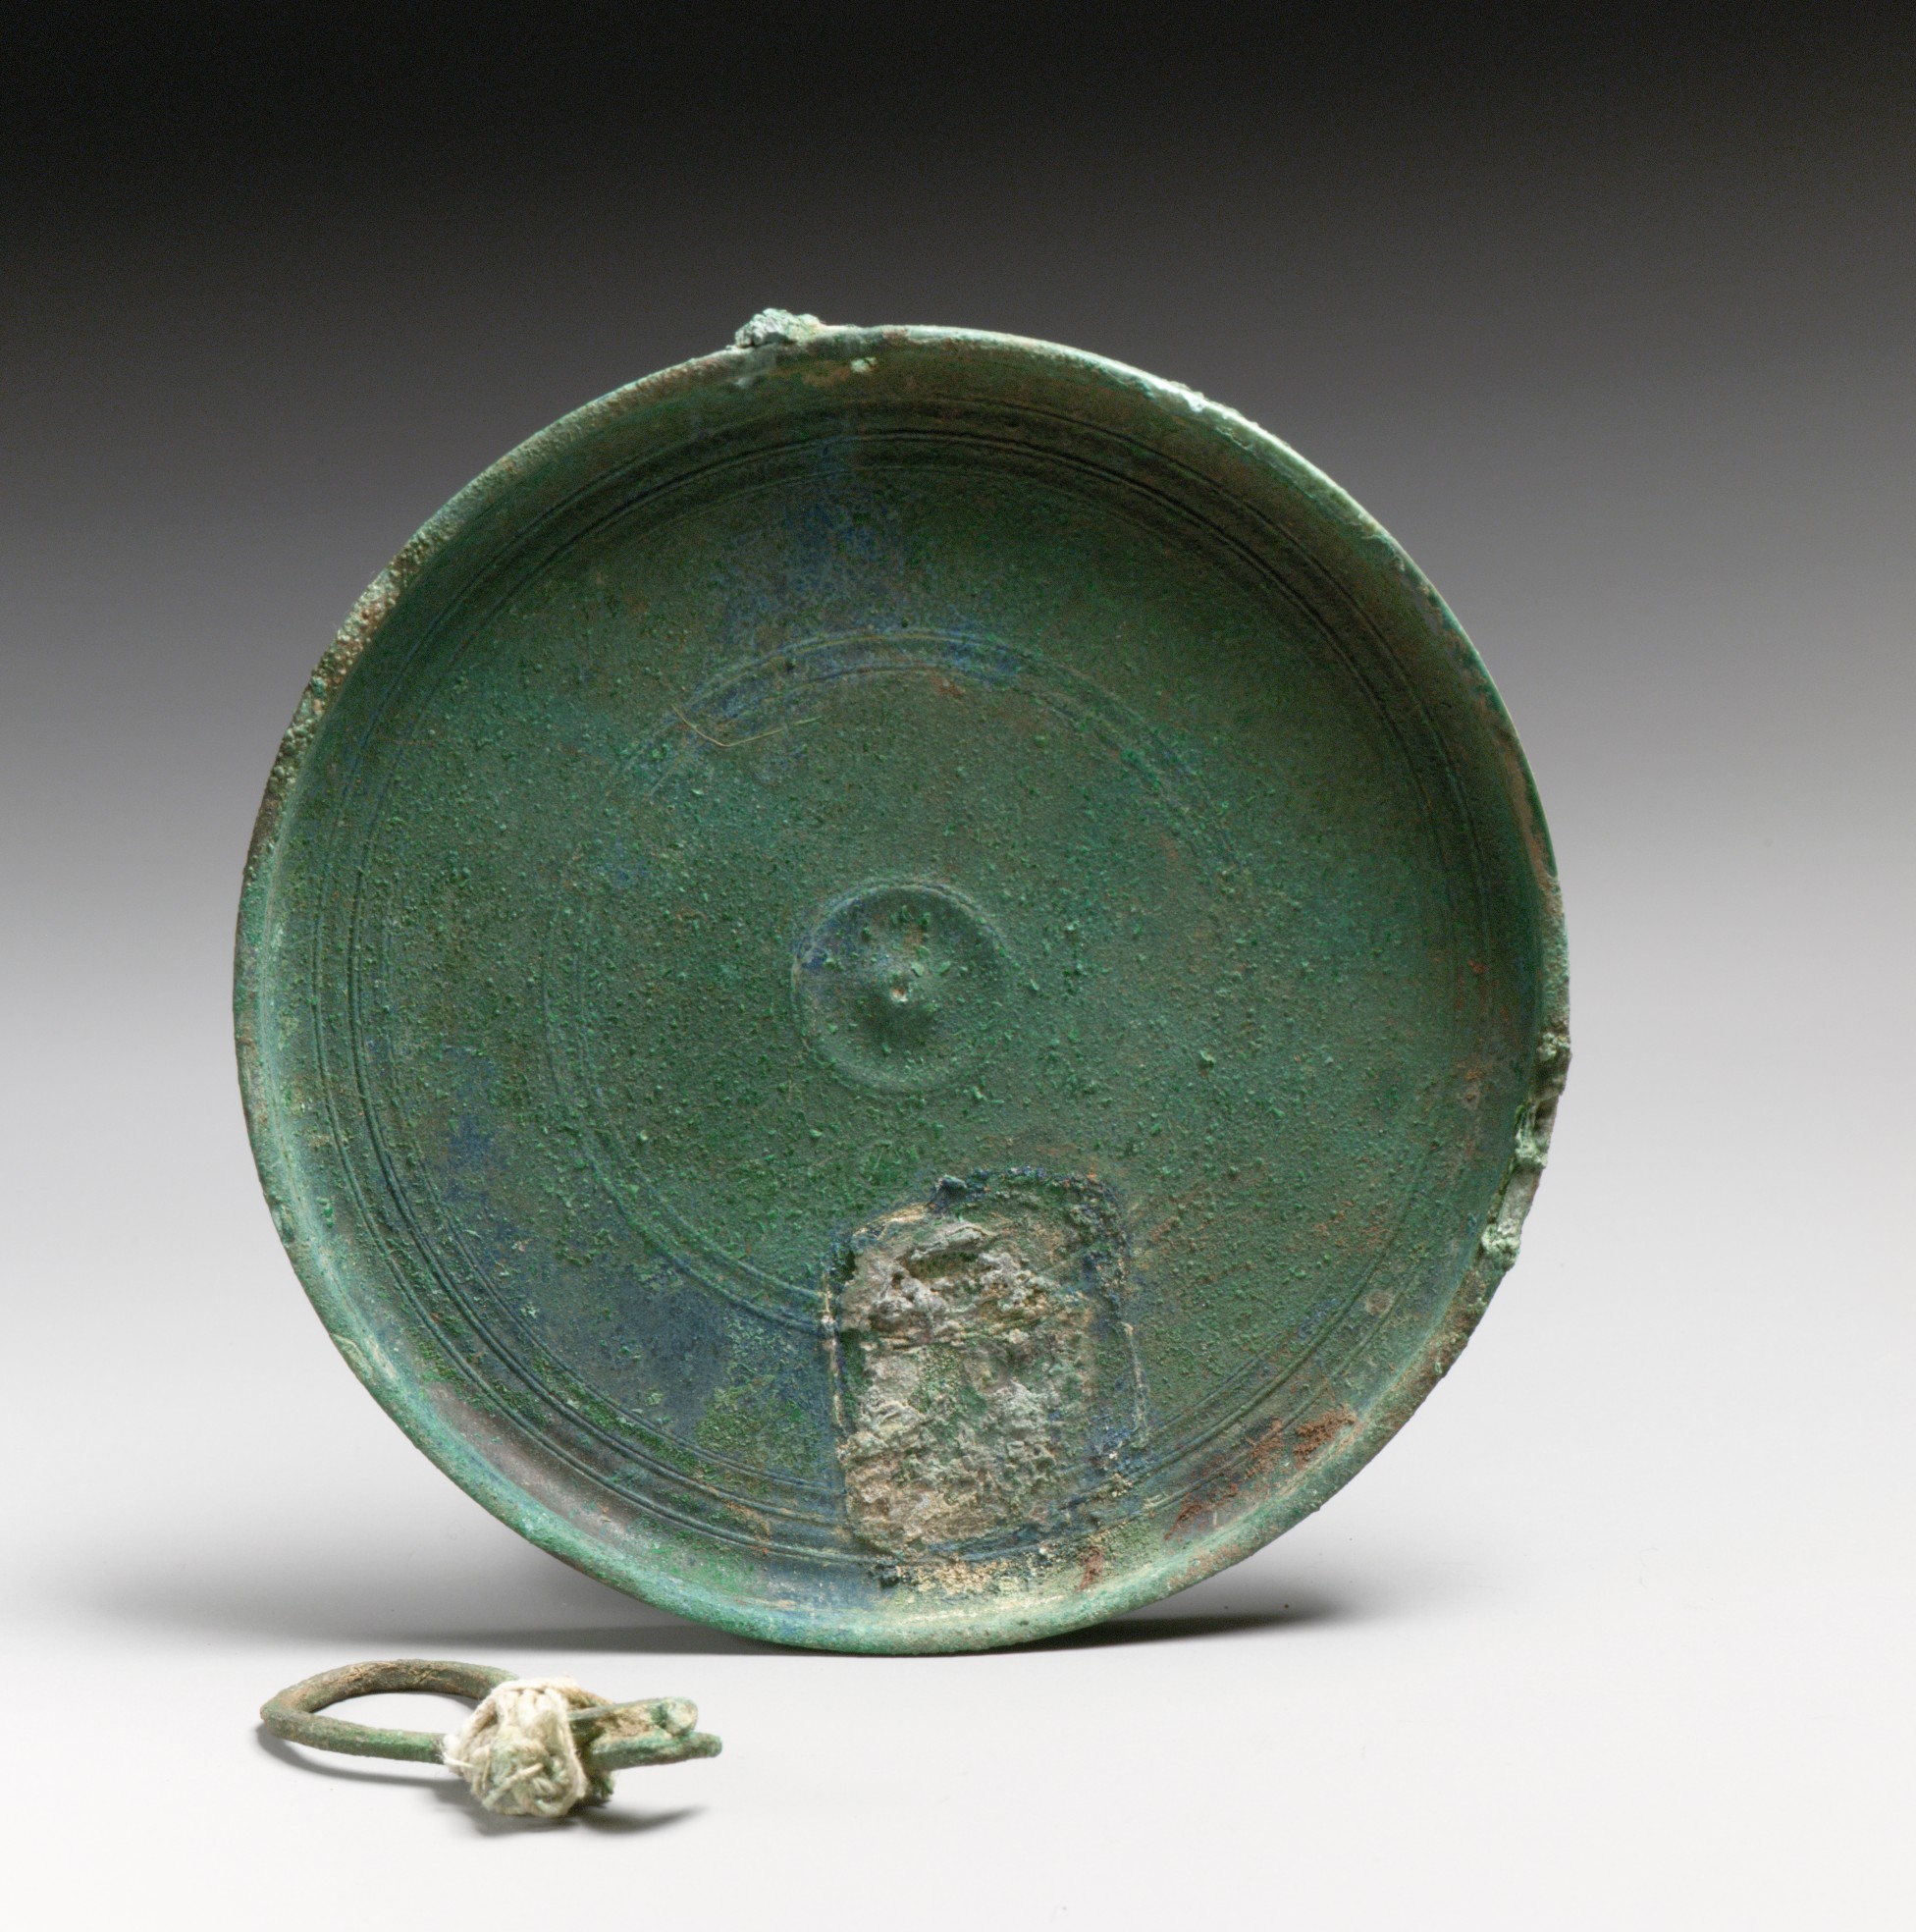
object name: mirror disk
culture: greek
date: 500-301 BCE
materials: bronze